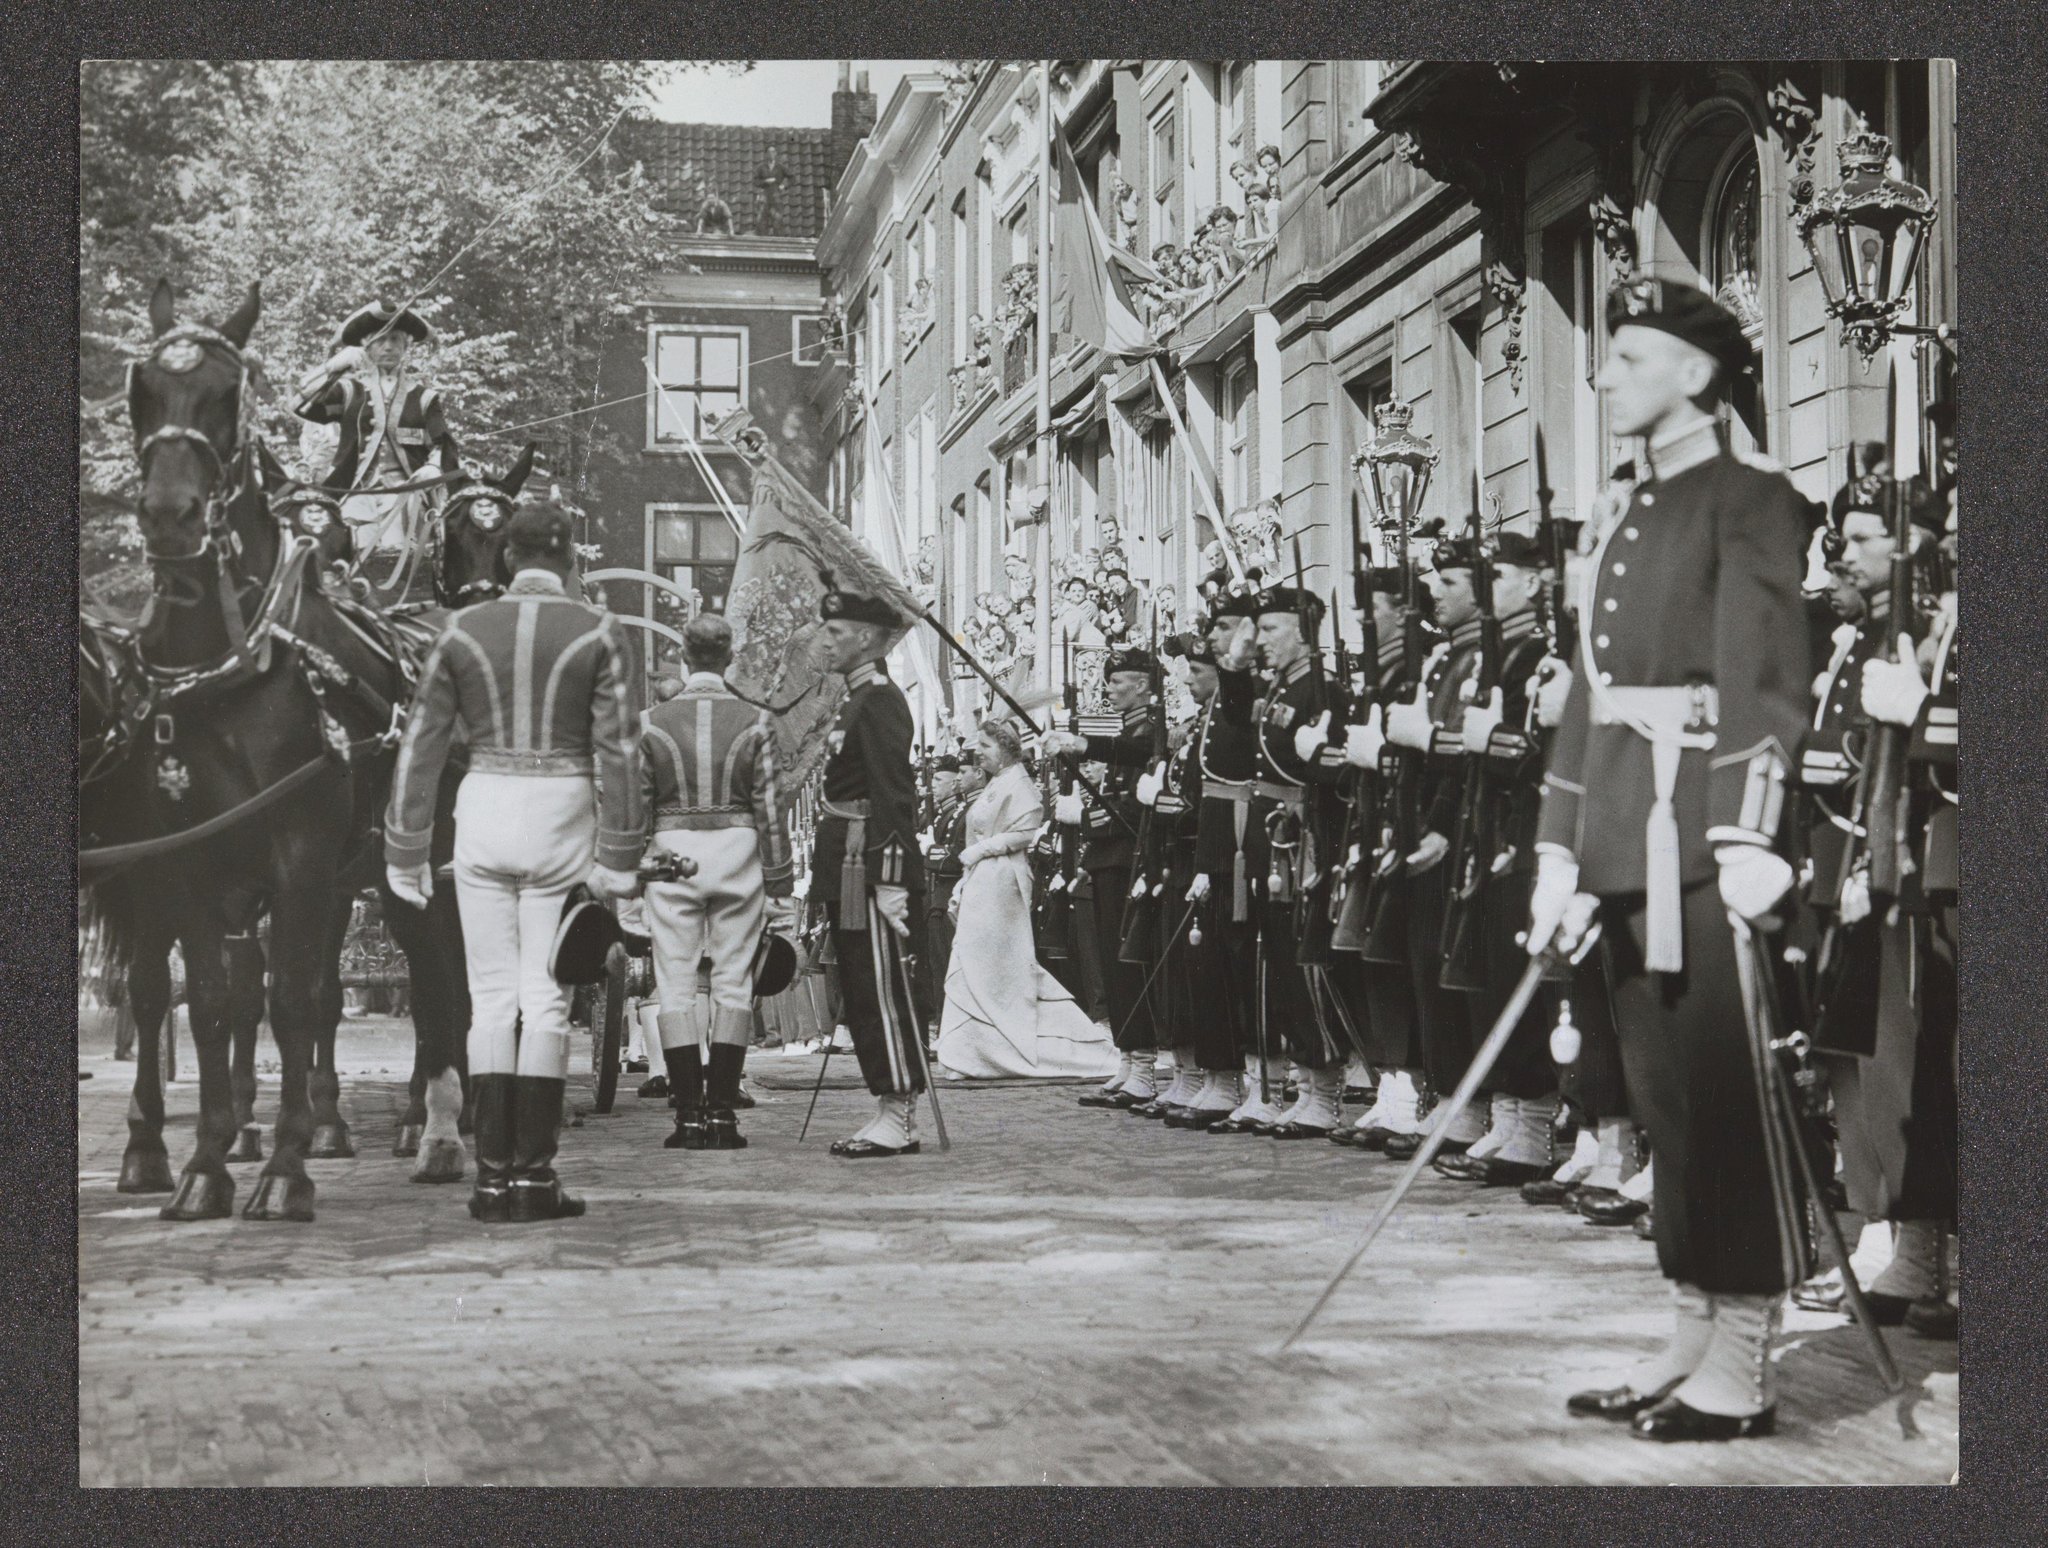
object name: photograph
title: Koningin Juliana tijdens het verlaten van het koninklijk paleis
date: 1955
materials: cardboard, paper, photographic support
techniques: gelatin silver print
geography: netherlands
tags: juliana of the netherlands, the hague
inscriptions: annotation: ‘H.M. Queen Juliana leaves the Royal Palace at The Hague and driven with the Golden Coach to the parliament’